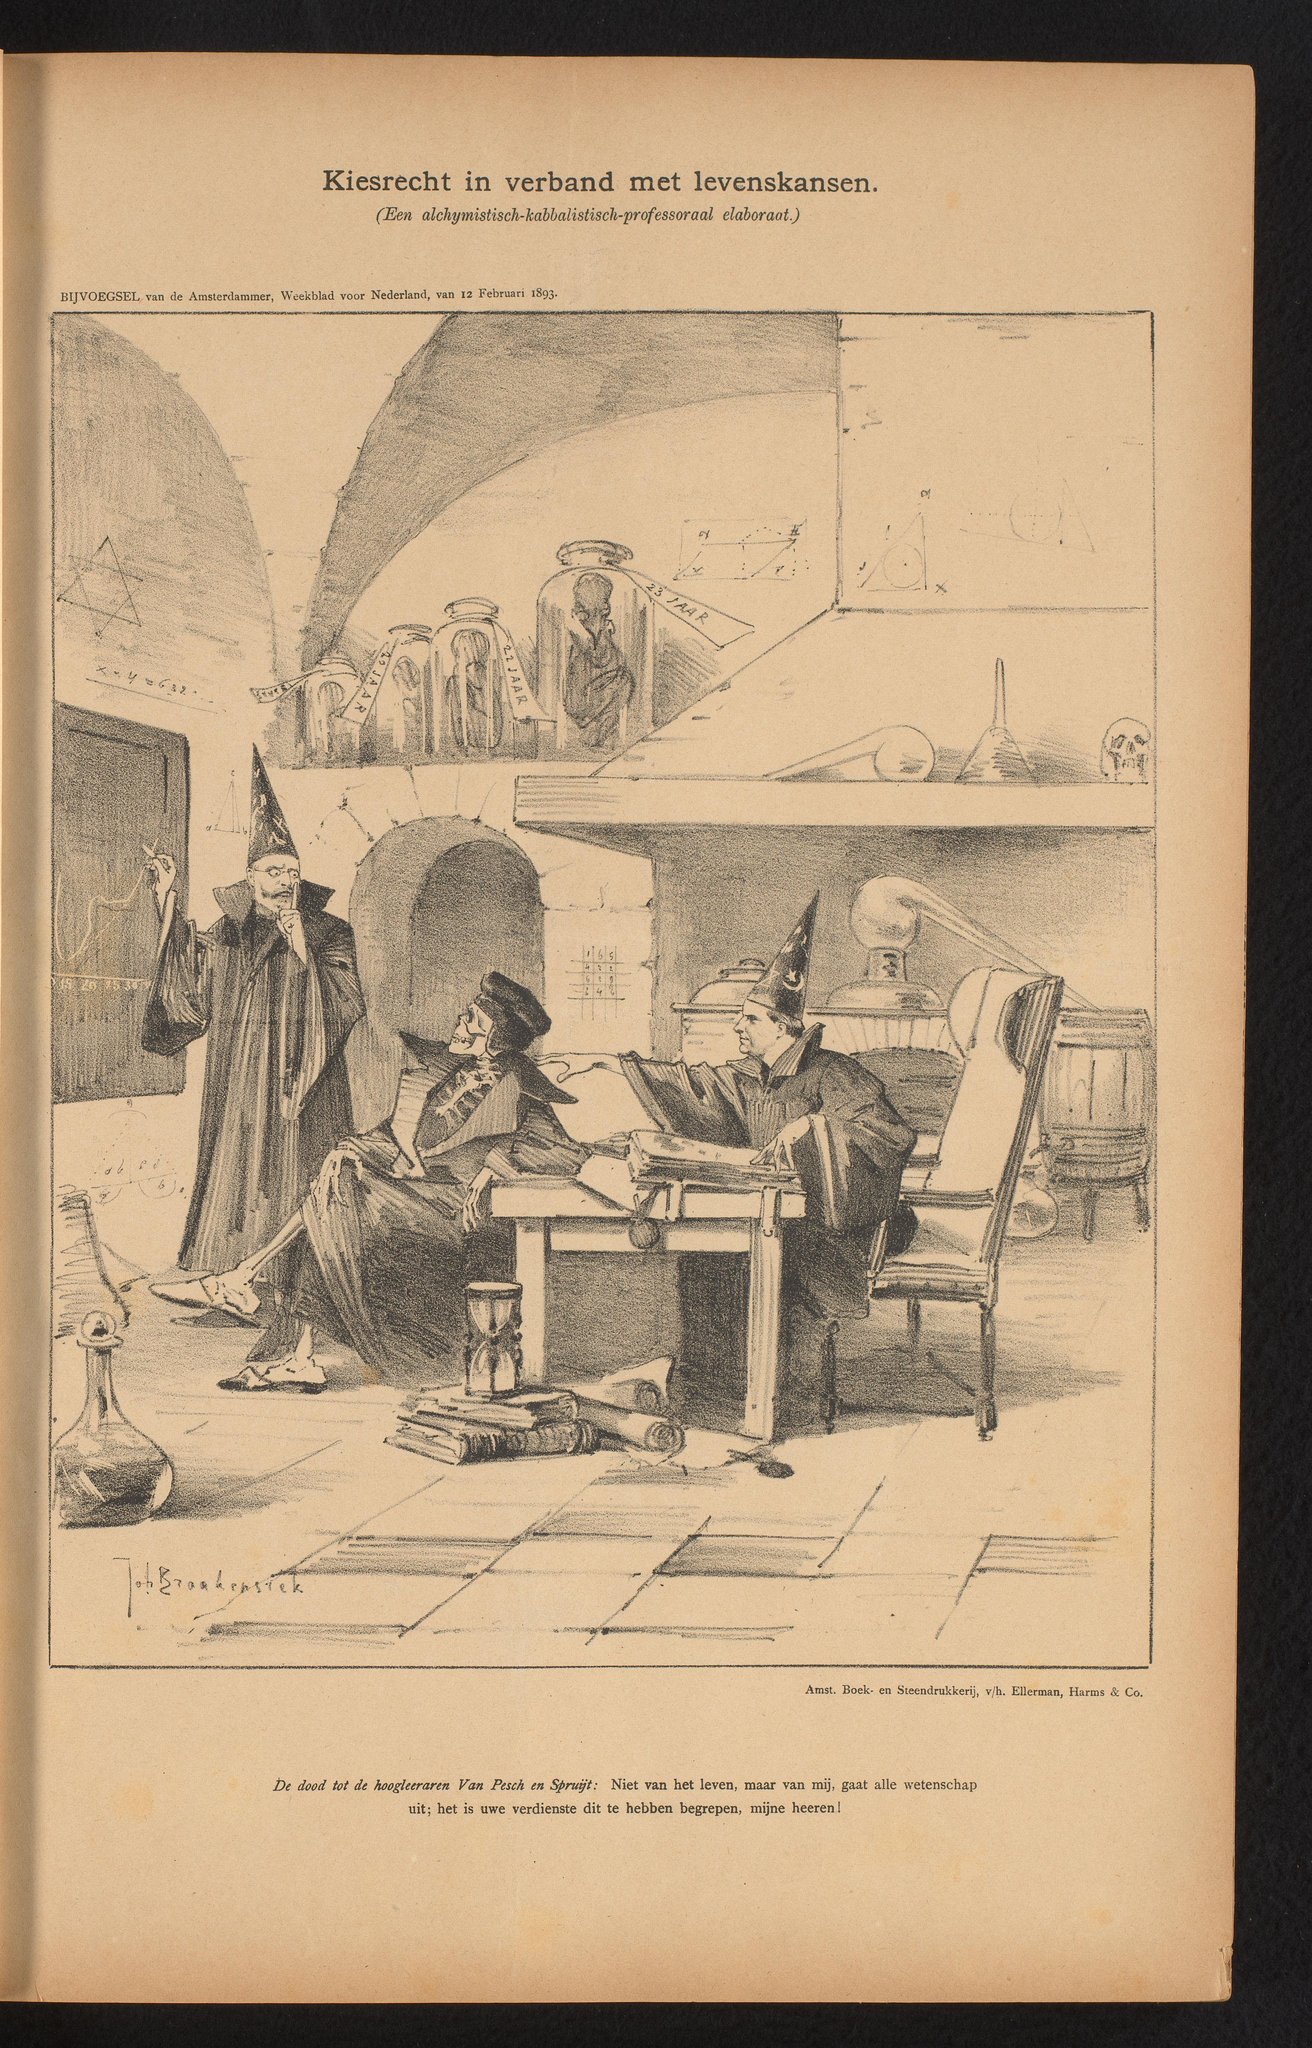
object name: cartoon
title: Kiesrecht in verband met levenskansen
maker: johan braakensiek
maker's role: draughtsman, print maker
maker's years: 1858-1940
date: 1893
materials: paper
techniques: lithograph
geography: amsterdam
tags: amsterdam, death as skeleton, the right to vote, the compulsory vote, alchemistic equipment, sorcerer, magician, wizard, warlock, alchemist at work, professor, political caricatures and satires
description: De Dood samen met de hoogleraren A.J. van Pesch en C. Bellaar Spruijt als alchemisten of tovenaars sprekend in een alchemistische werkplaats over leeftijd en kiesrecht.